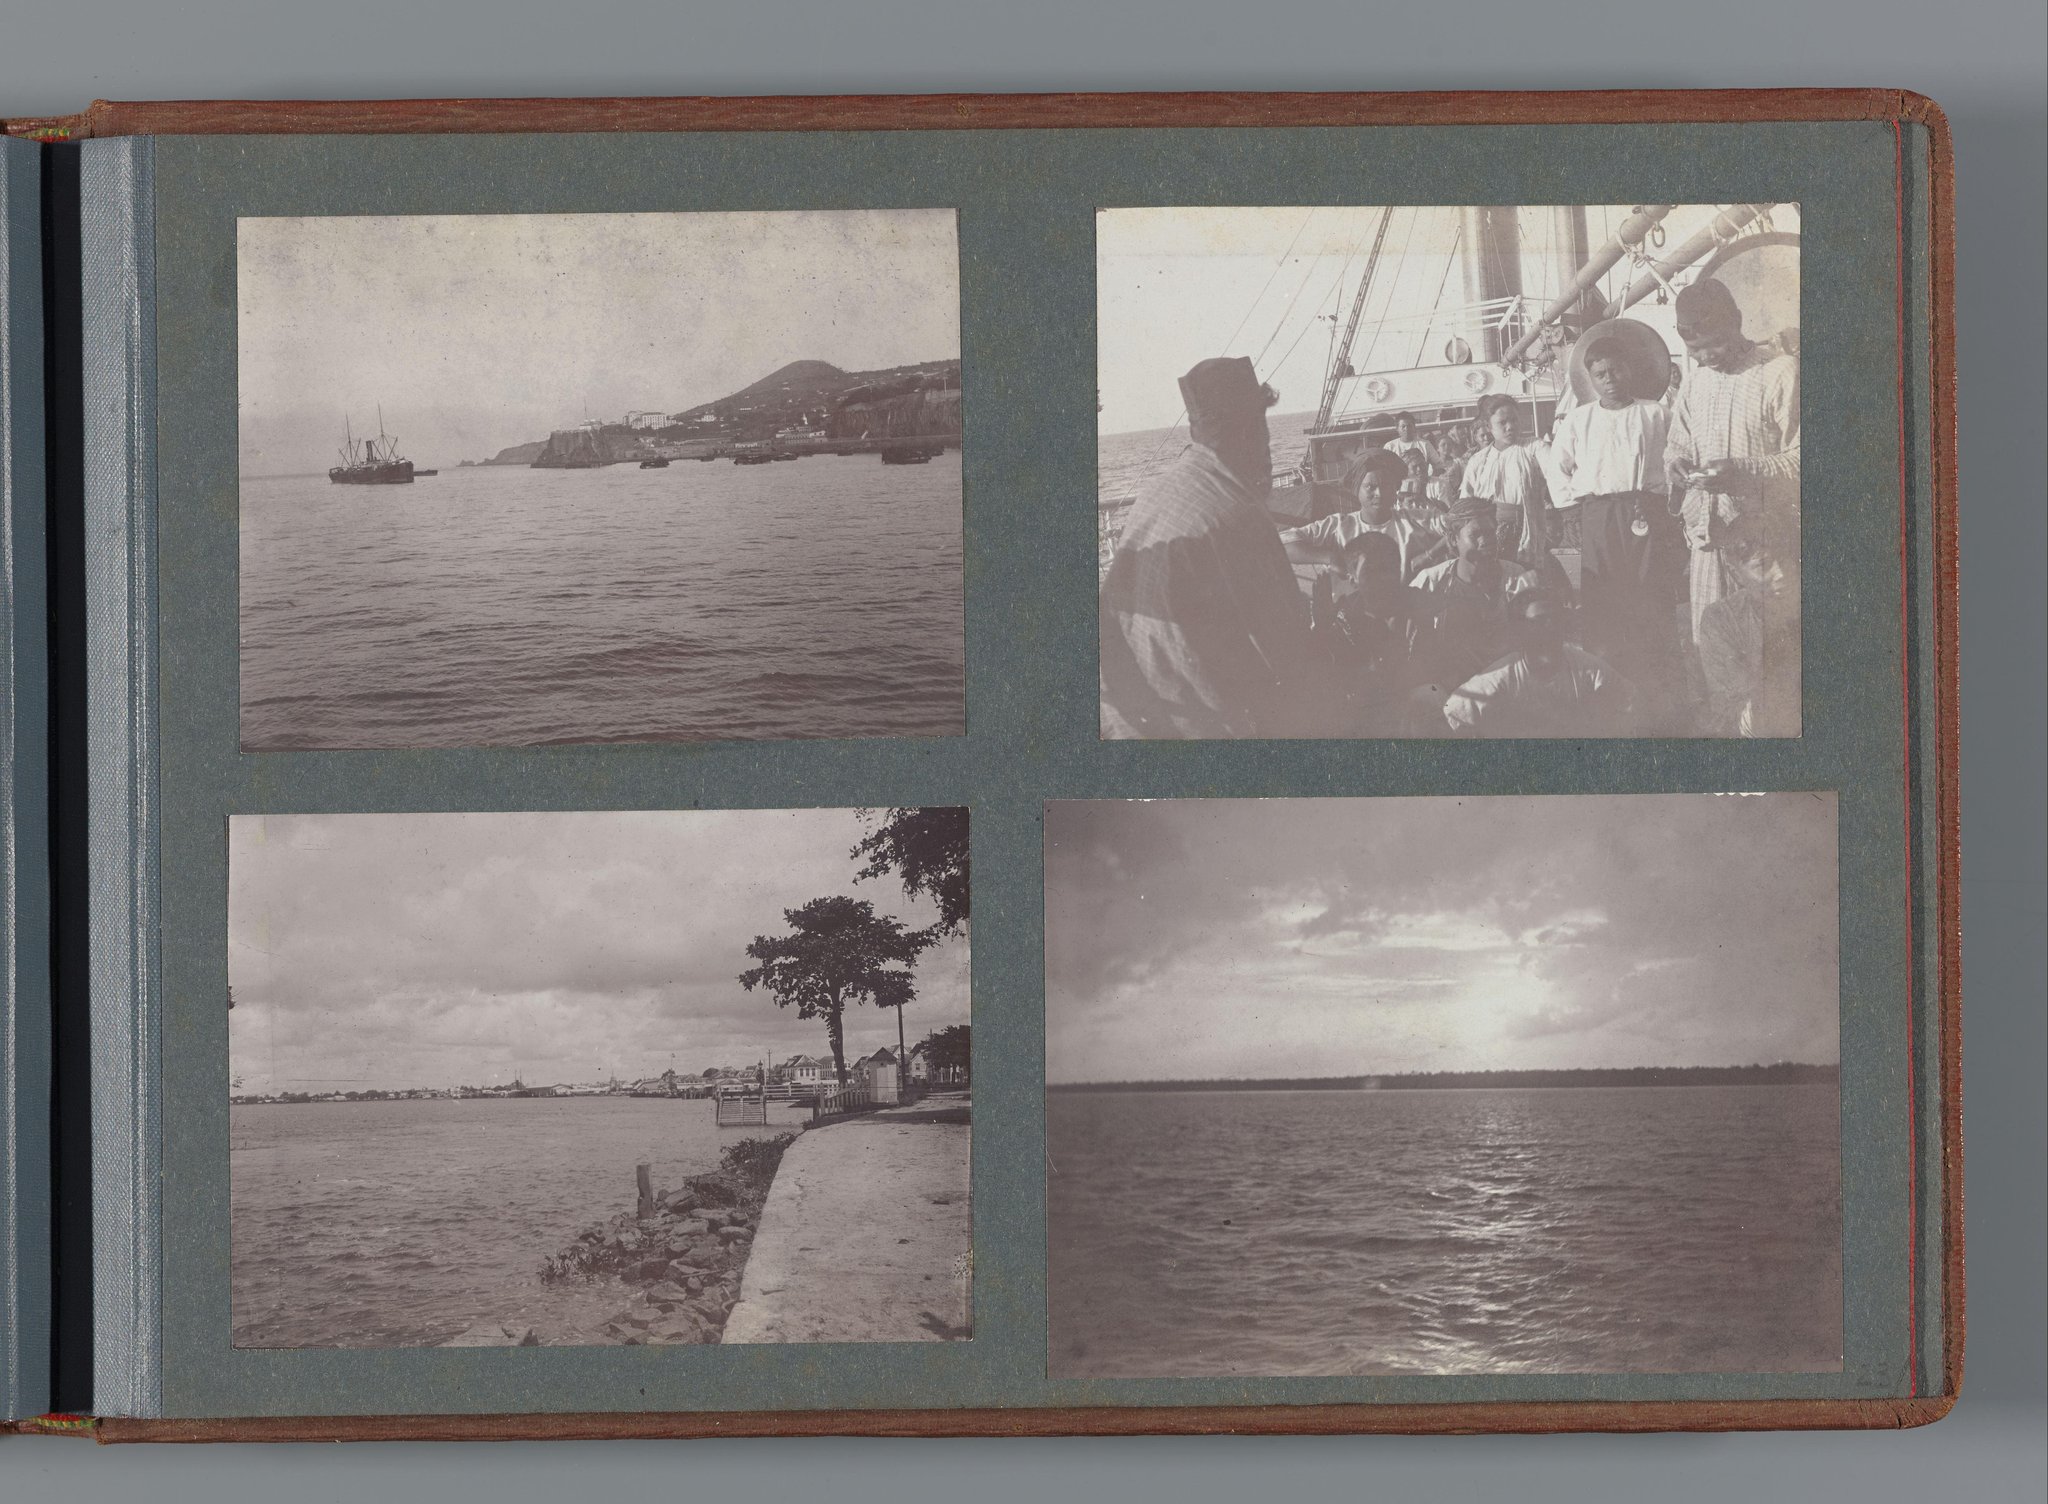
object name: photograph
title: Kustlijn van Paramaribo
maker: Anonymous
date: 1905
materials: cardboard, paper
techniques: photography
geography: paramaribo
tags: paramaribo (stad)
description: Kustlijn van Paramaribo. Onderdeel van fotoalbum 'Suriname'.